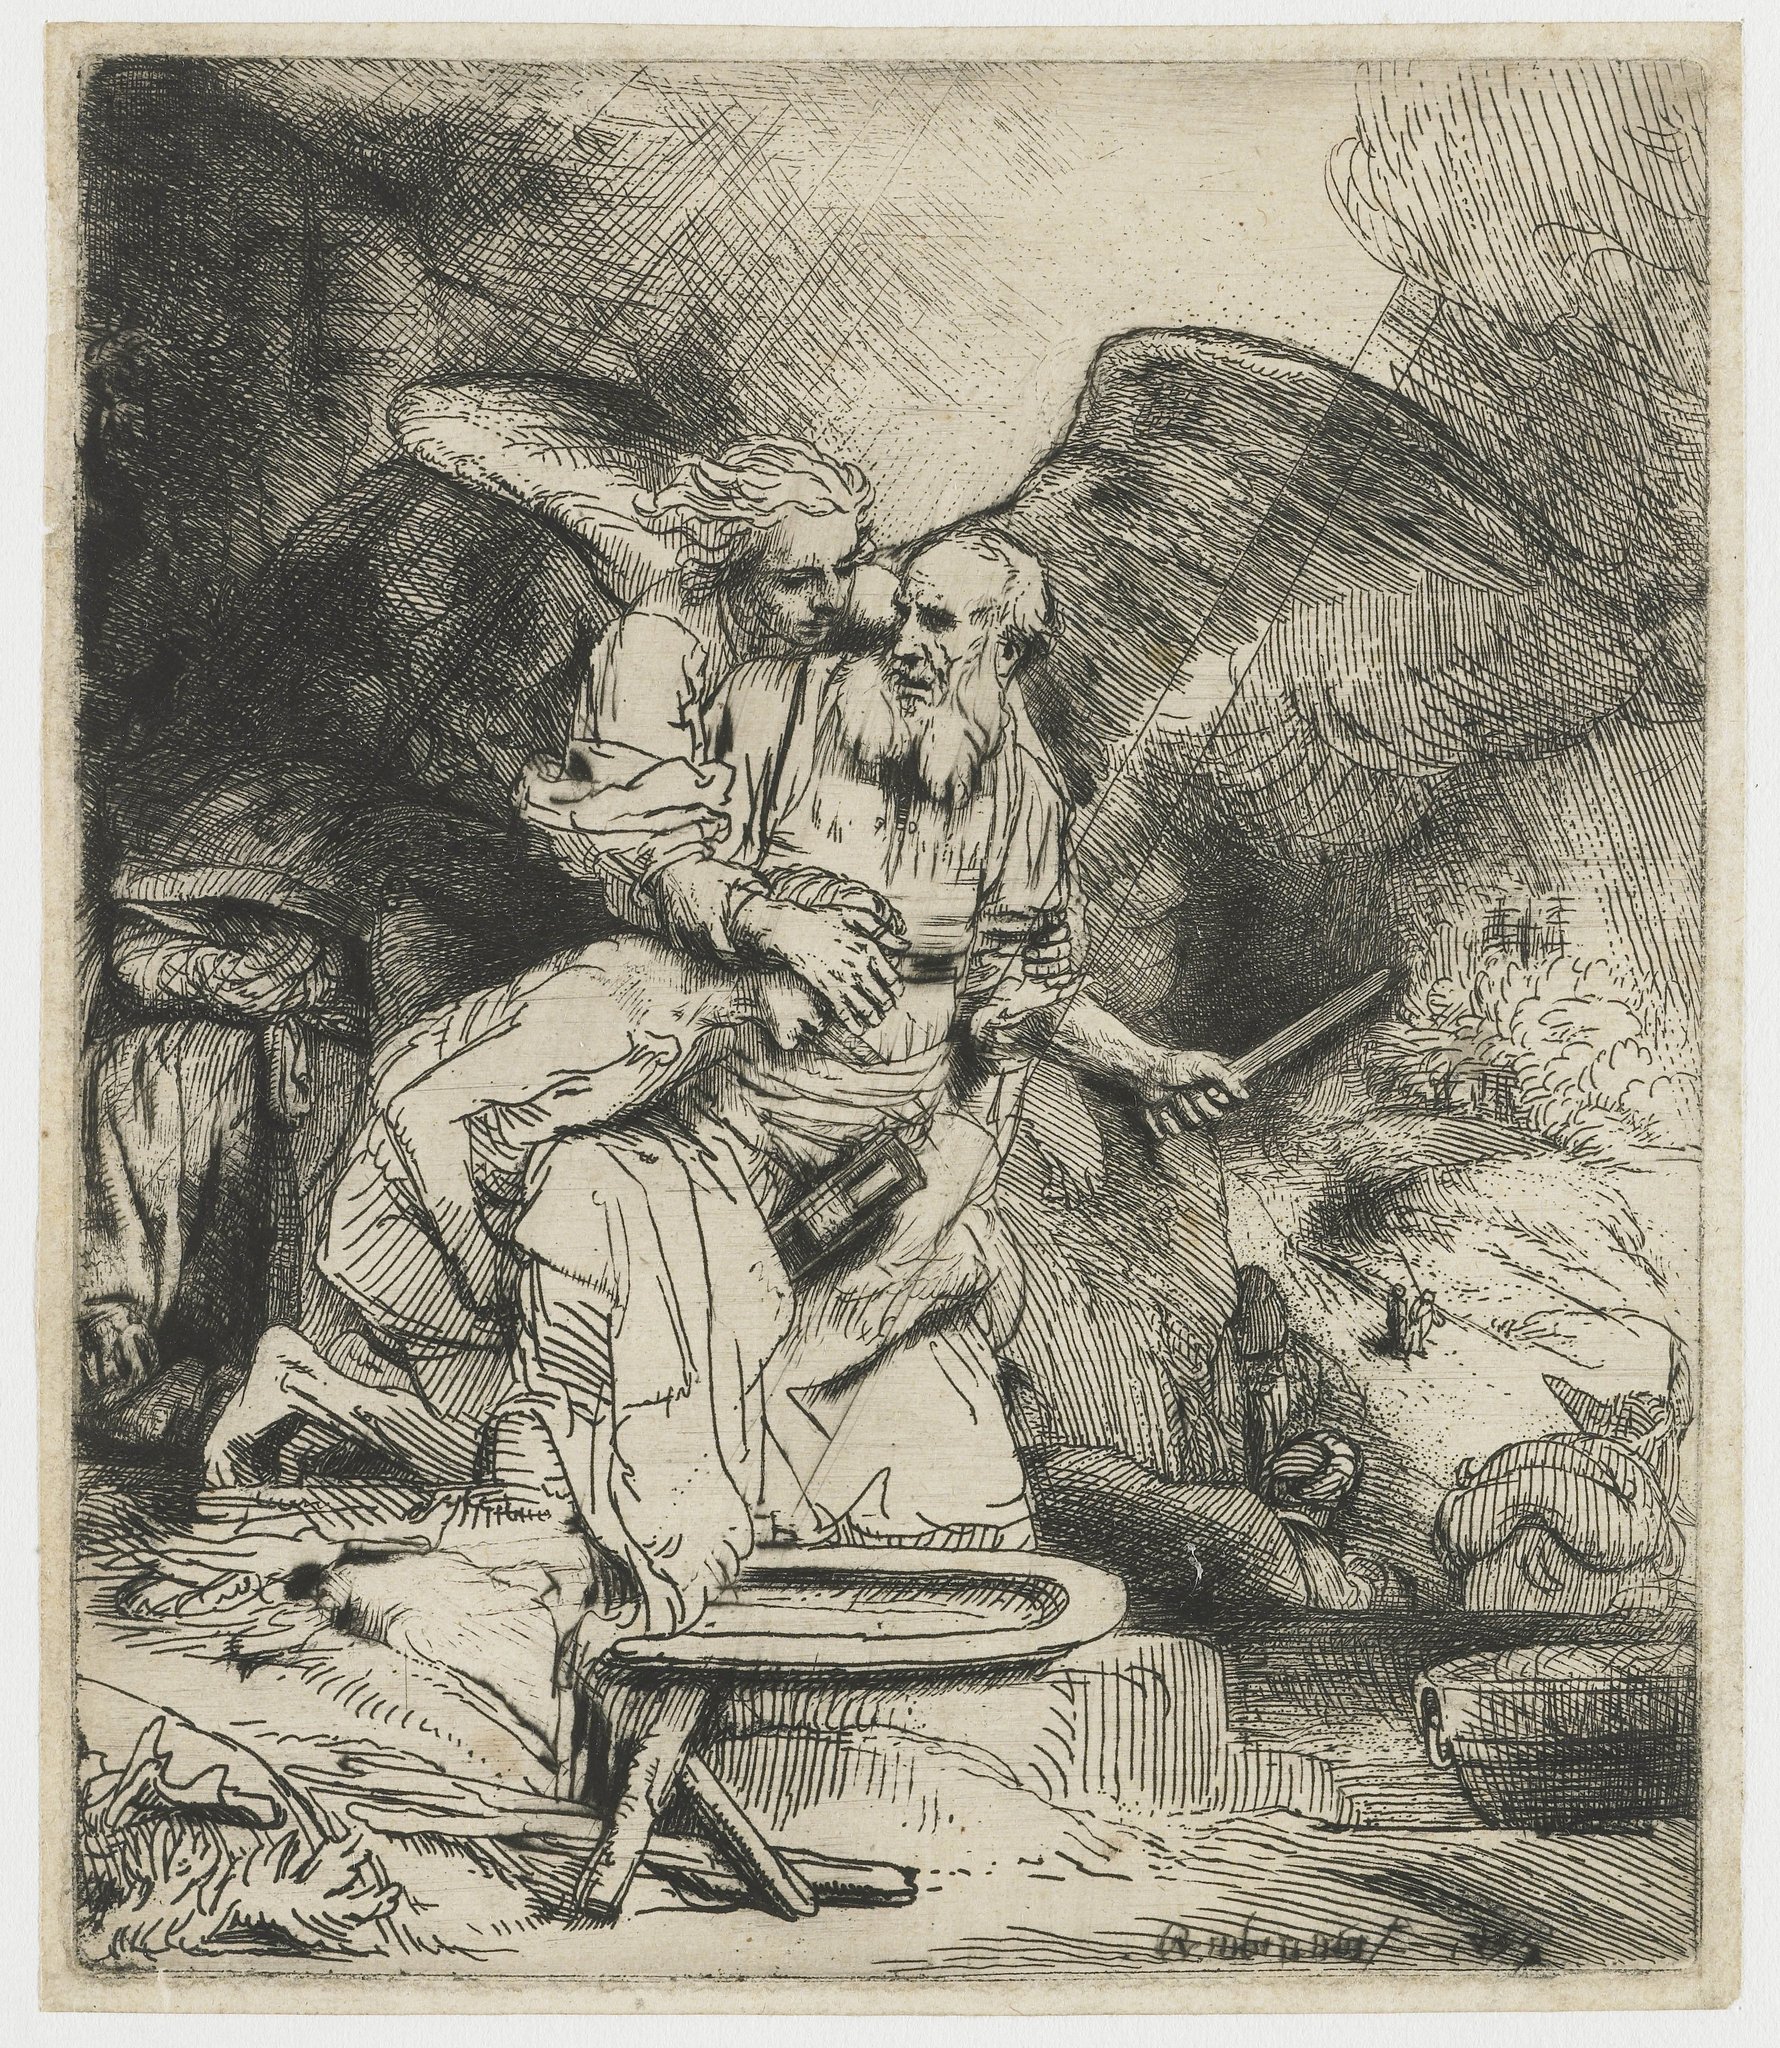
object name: print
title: Abraham's sacrifice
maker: rembrandt van rijn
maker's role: draughtsman, painter, print maker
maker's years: 1606-1669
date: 1655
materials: paper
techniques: drypoint, etching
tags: the sacrifice of isaac (genesis 22)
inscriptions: signature and date: ‘Rembrandt f 1655’, mark: Lugt 2228